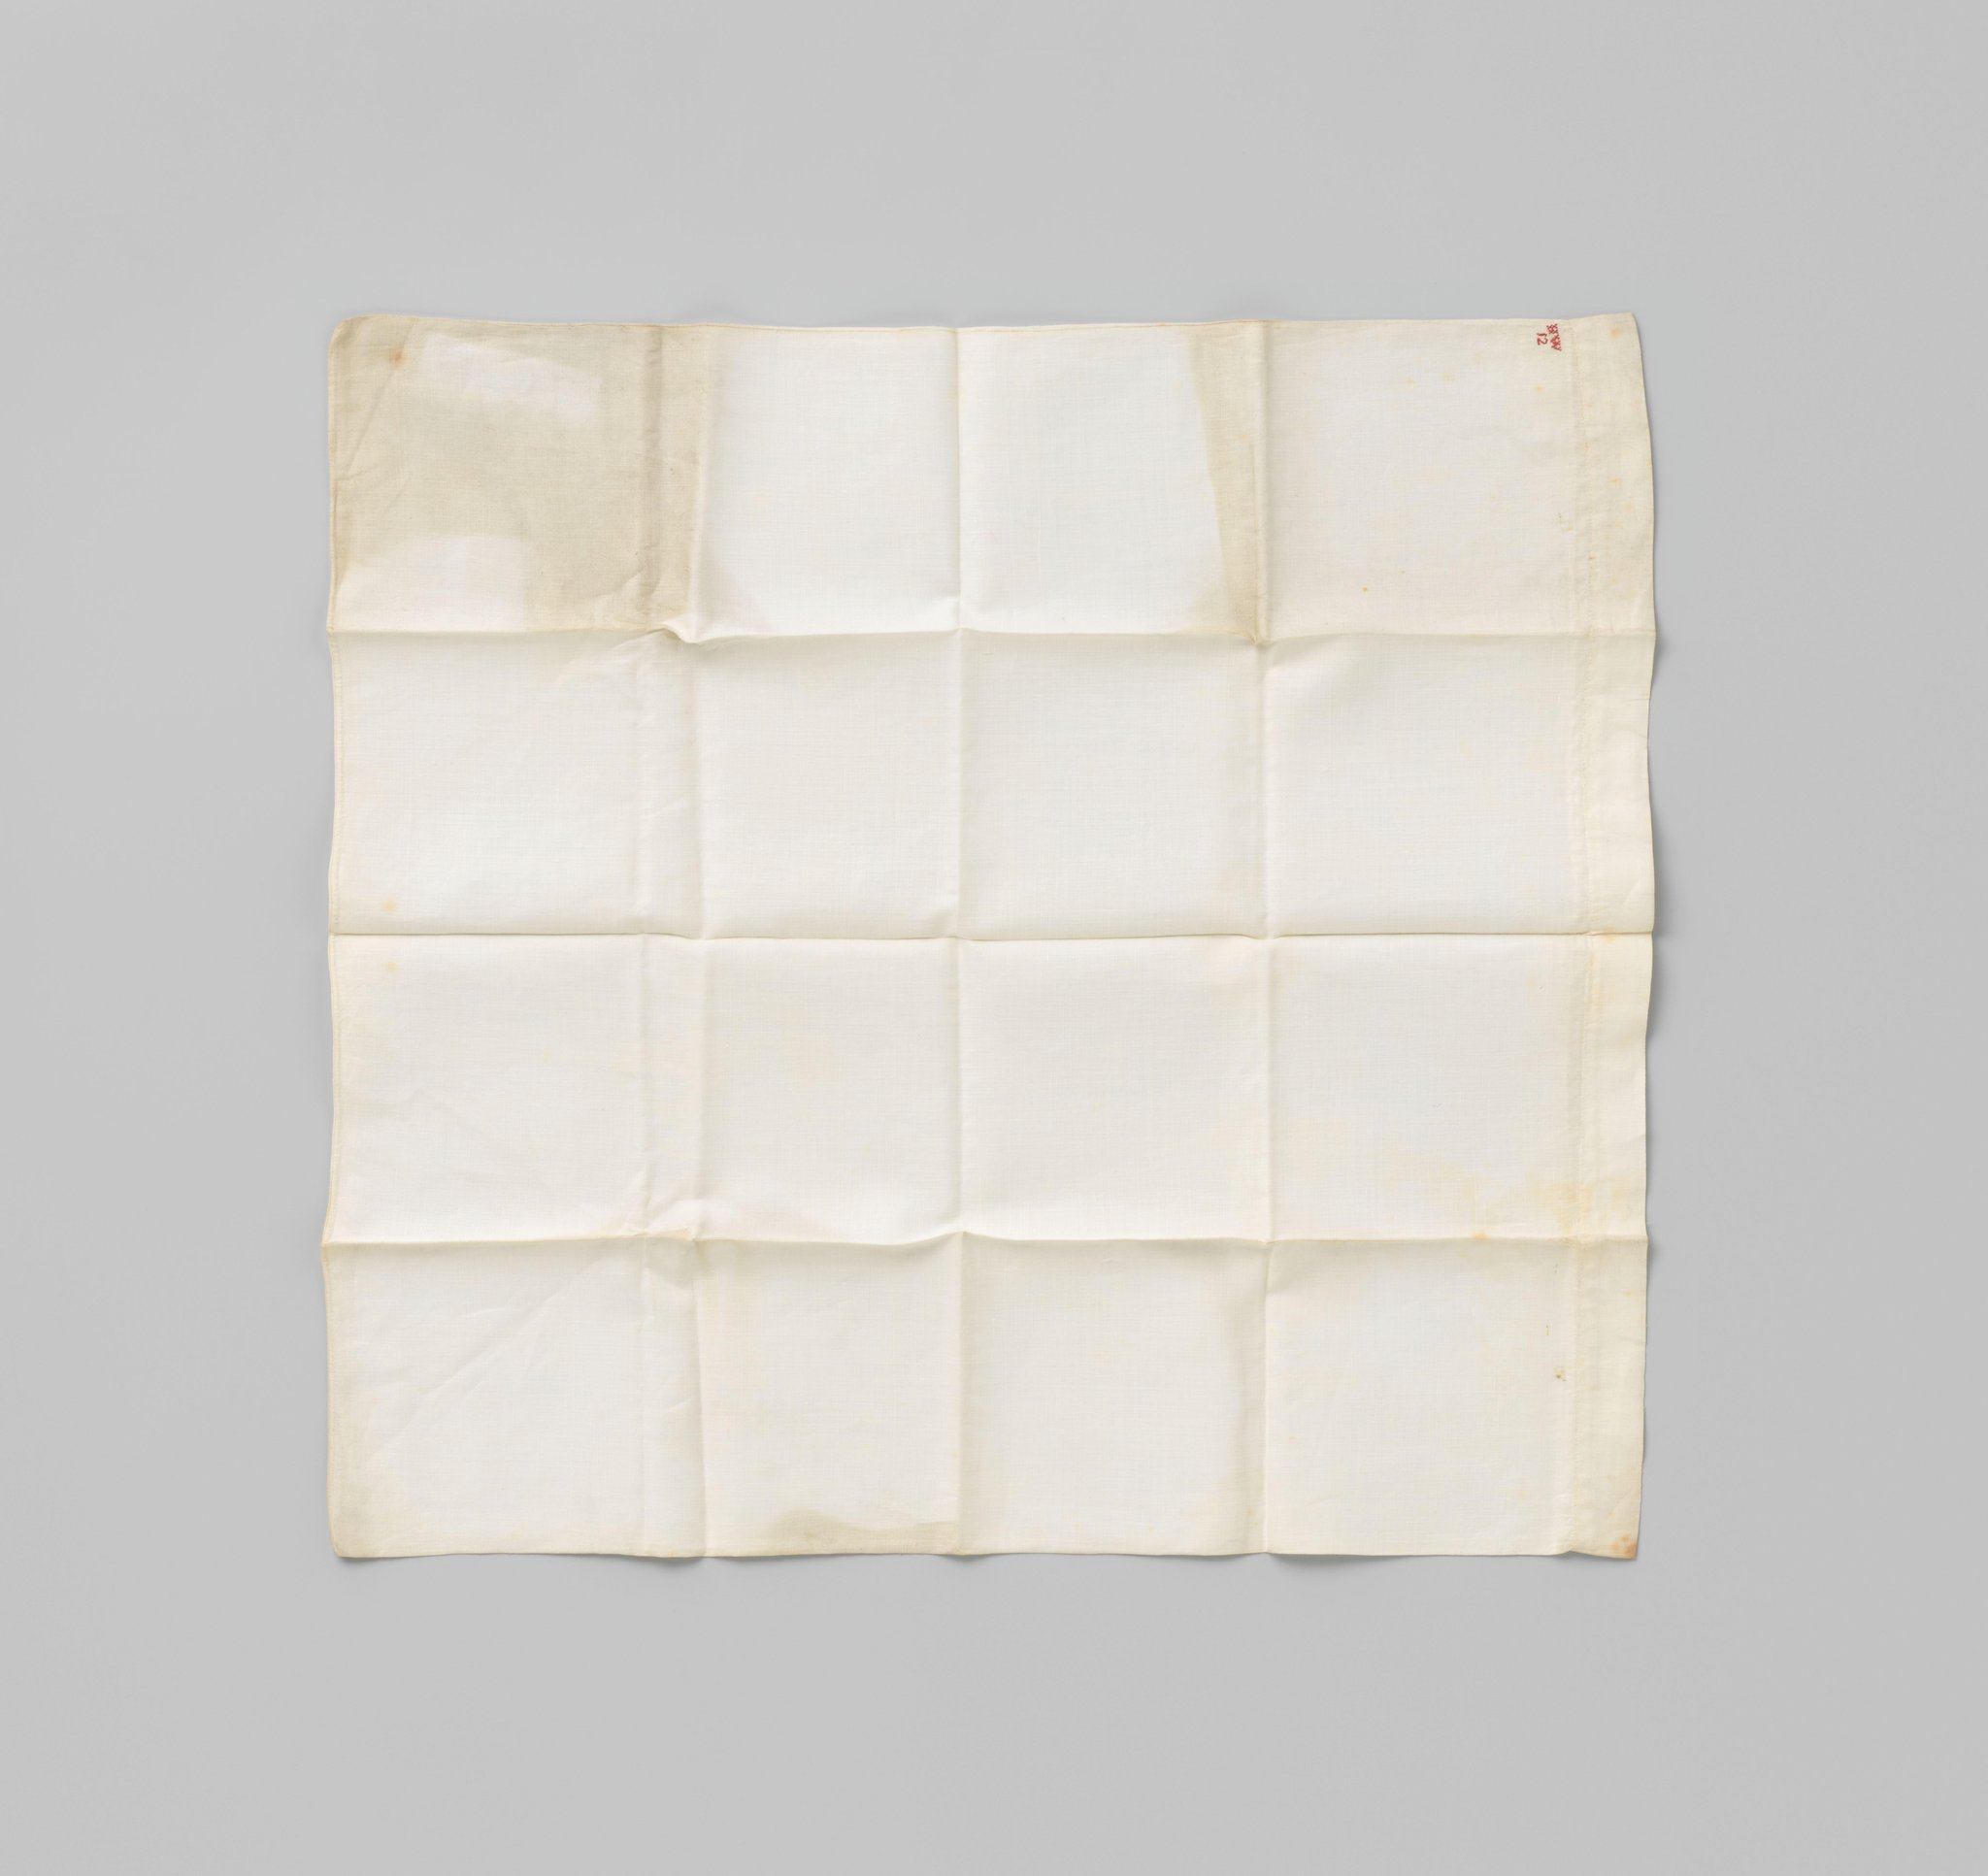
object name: sloop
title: Sloop van linnen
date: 1820-1850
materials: linen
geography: northern netherlands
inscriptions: mark: ‘HW12’